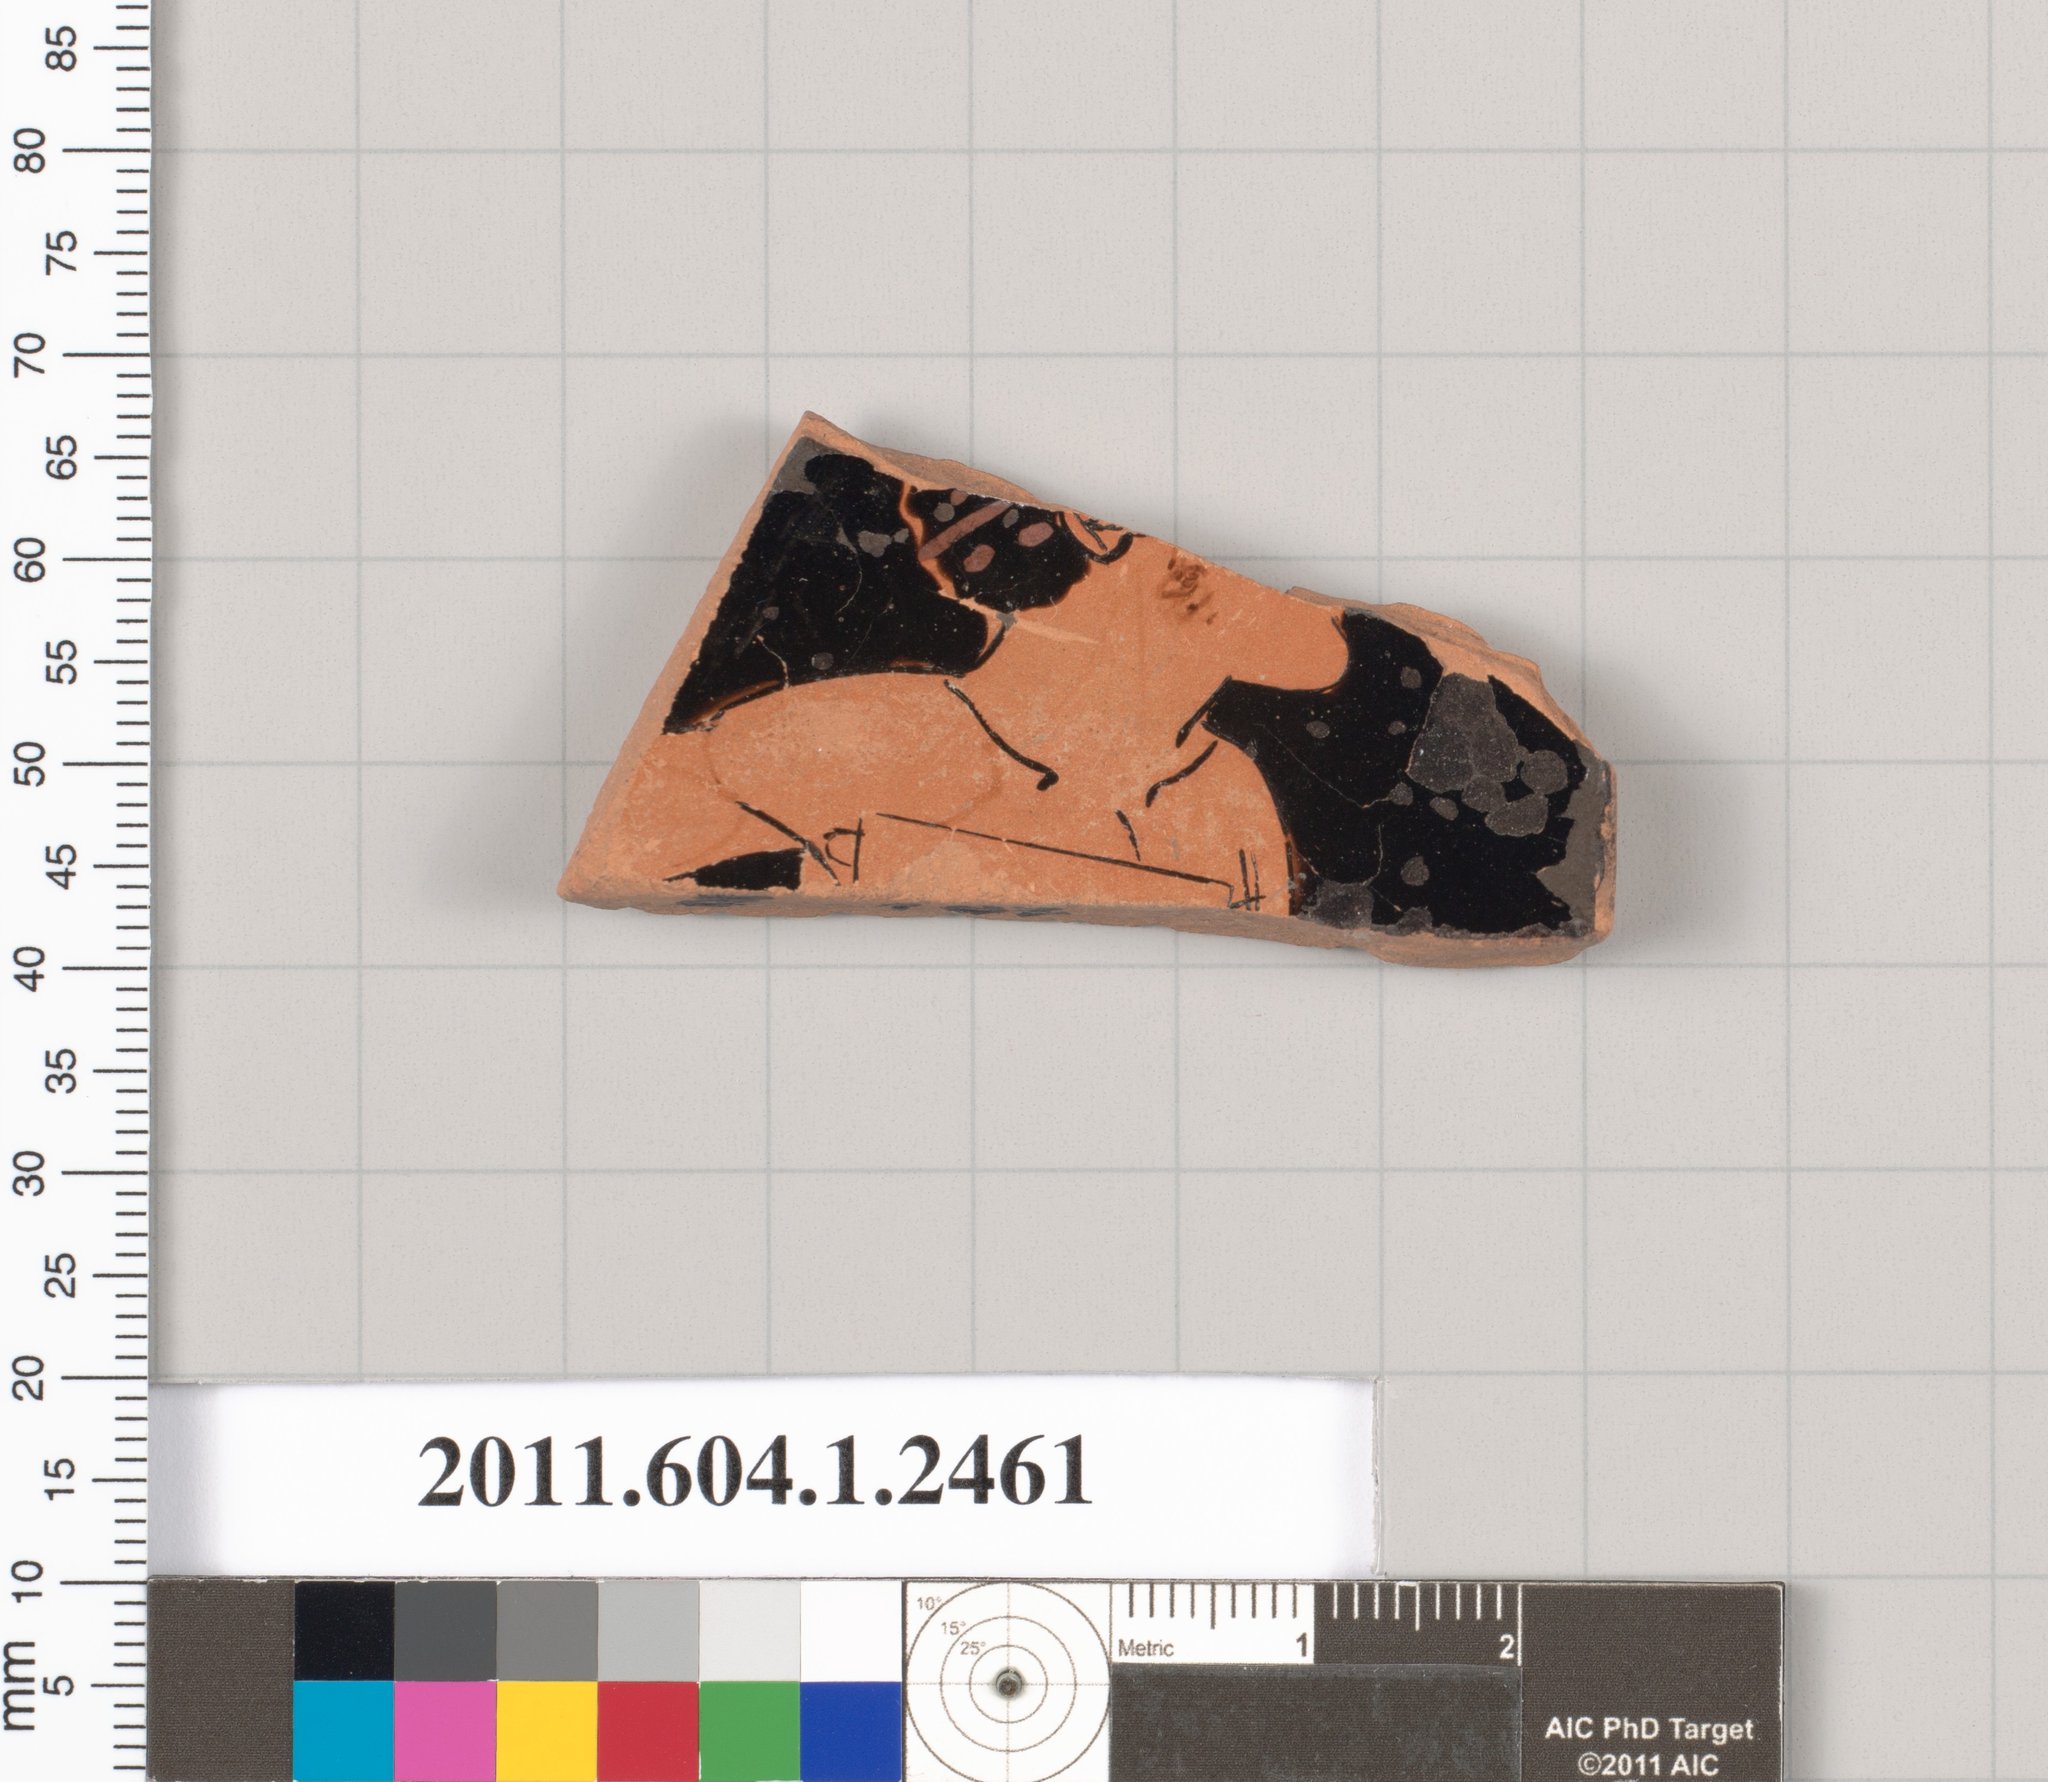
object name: kylix fragment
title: Terracotta fragment of a kylix (drinking cup)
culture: greek, attic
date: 520-500 BCE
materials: terracotta